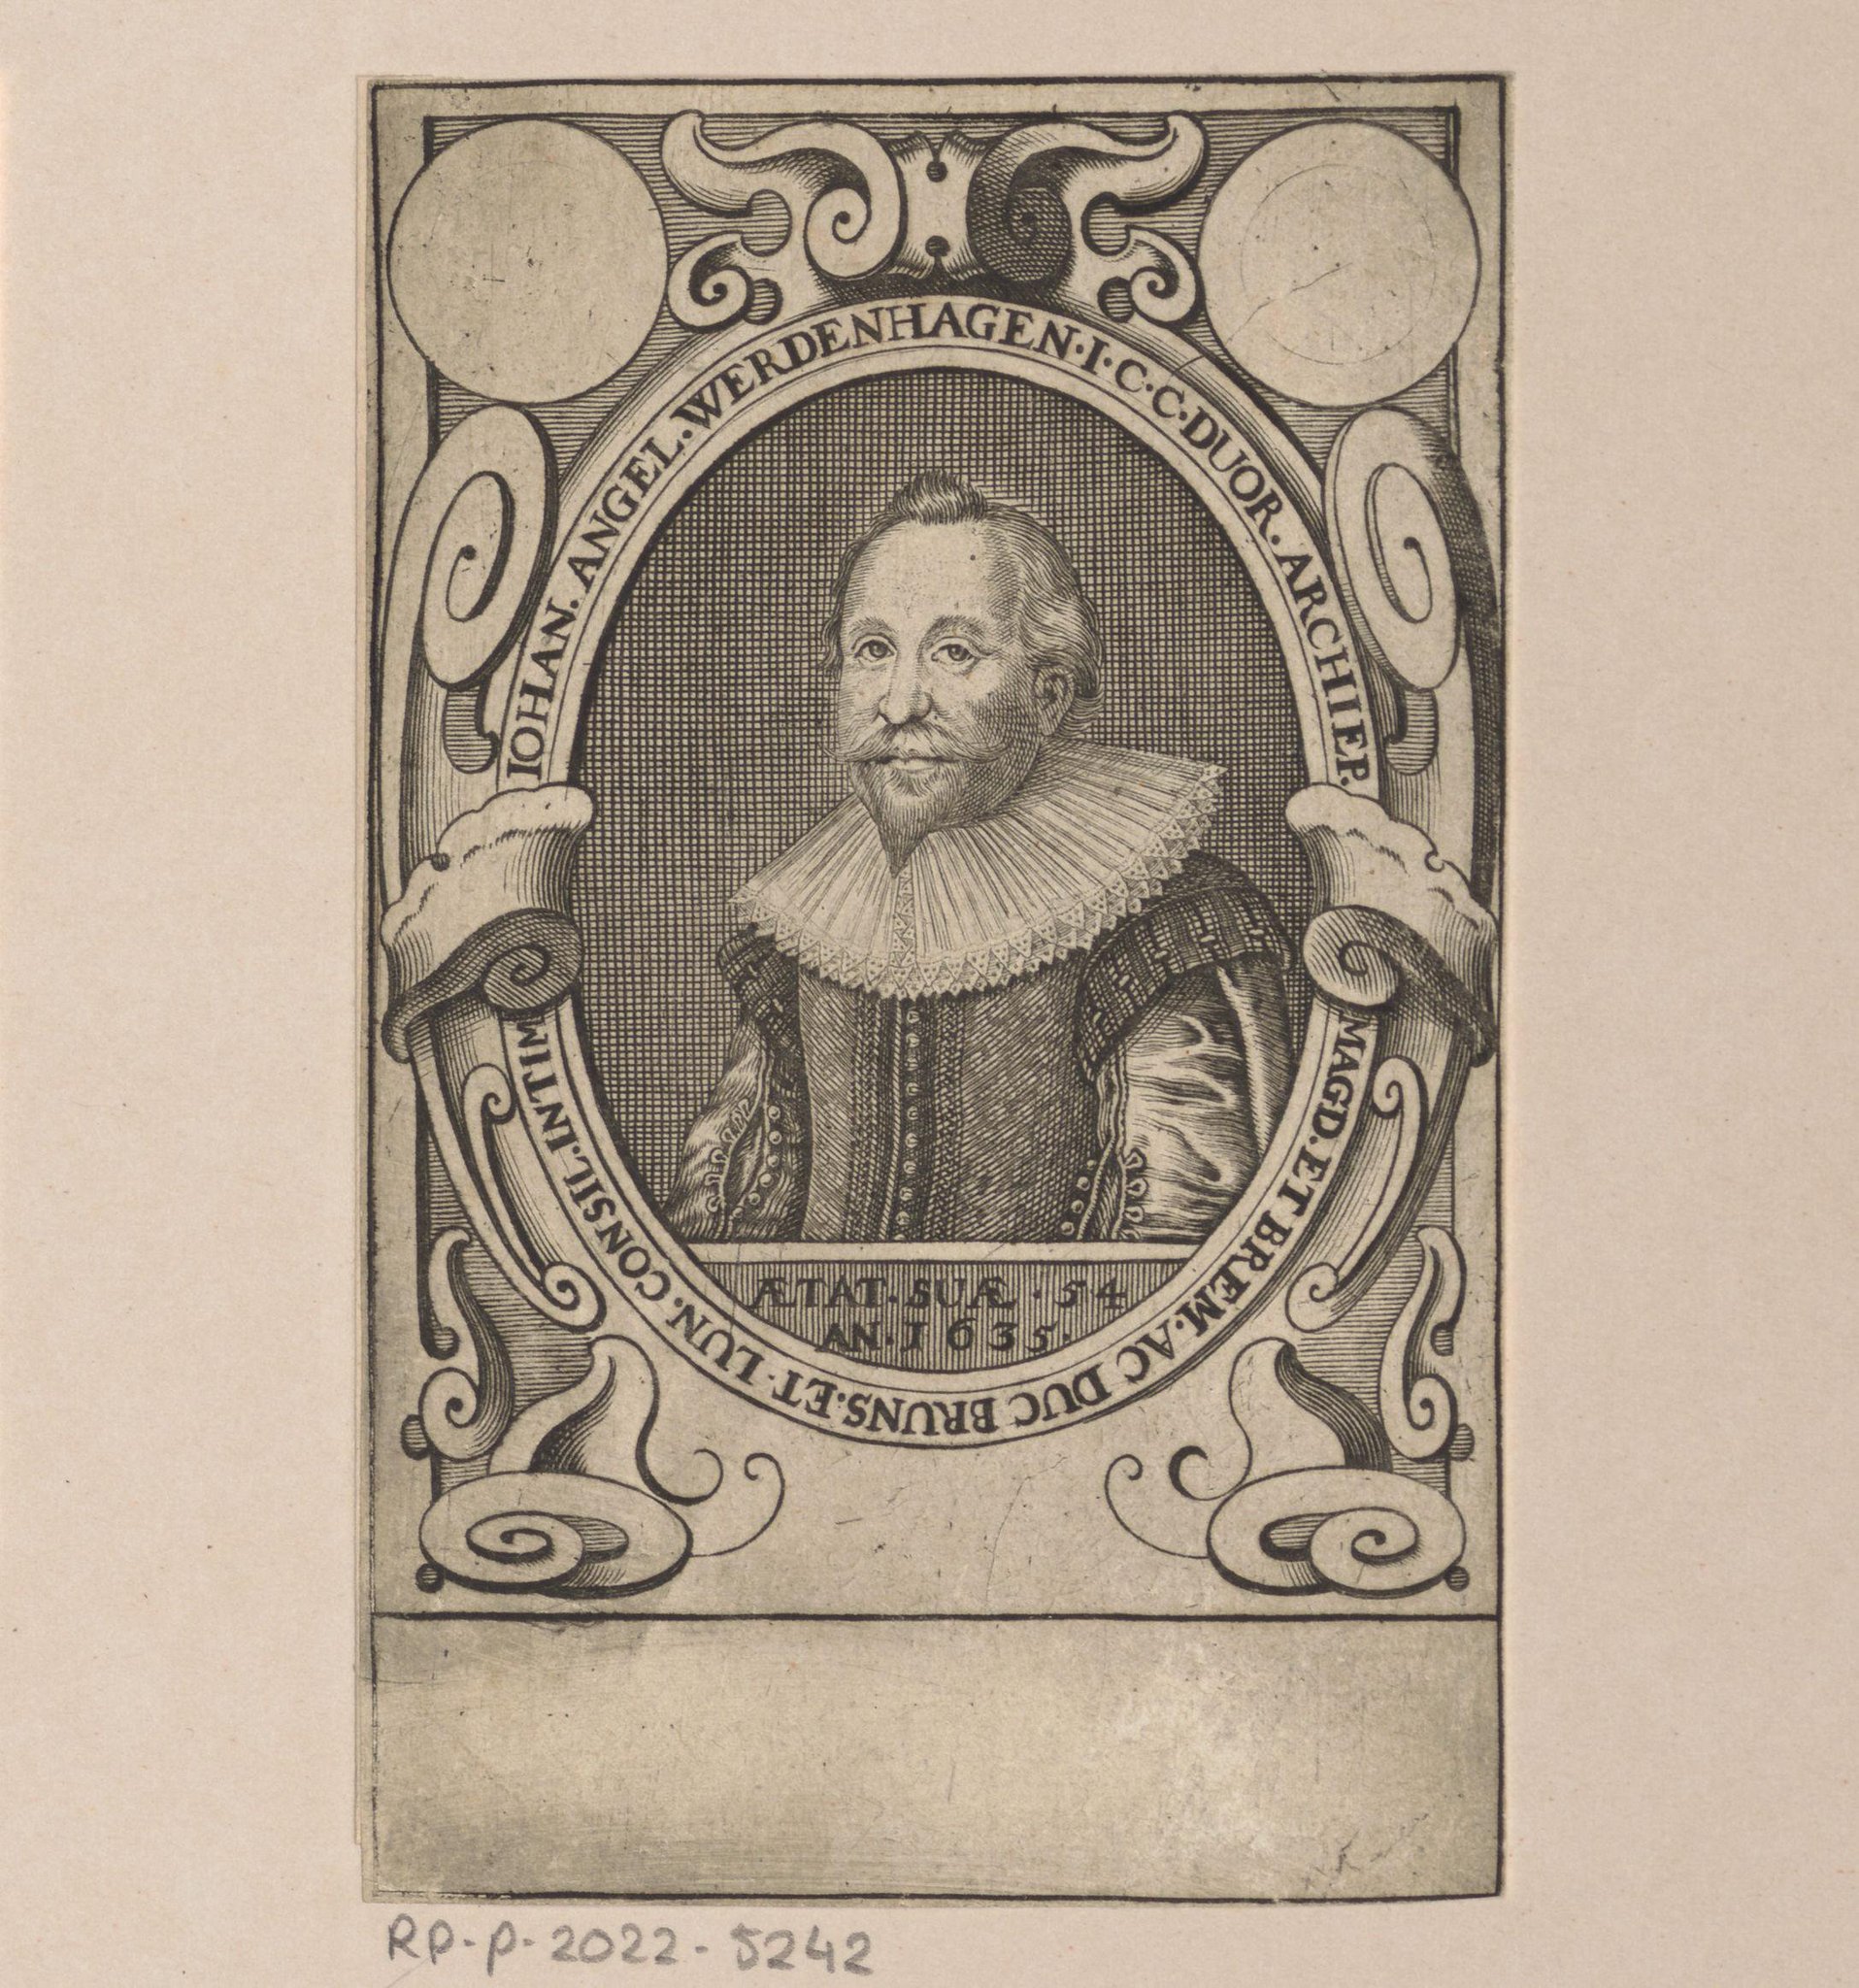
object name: print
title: Portret van Johann Angelius Werdenhagen op 54-jarige leeftijd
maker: Anonymous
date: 1635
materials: paper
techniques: engraving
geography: northern netherlands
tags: historical persons